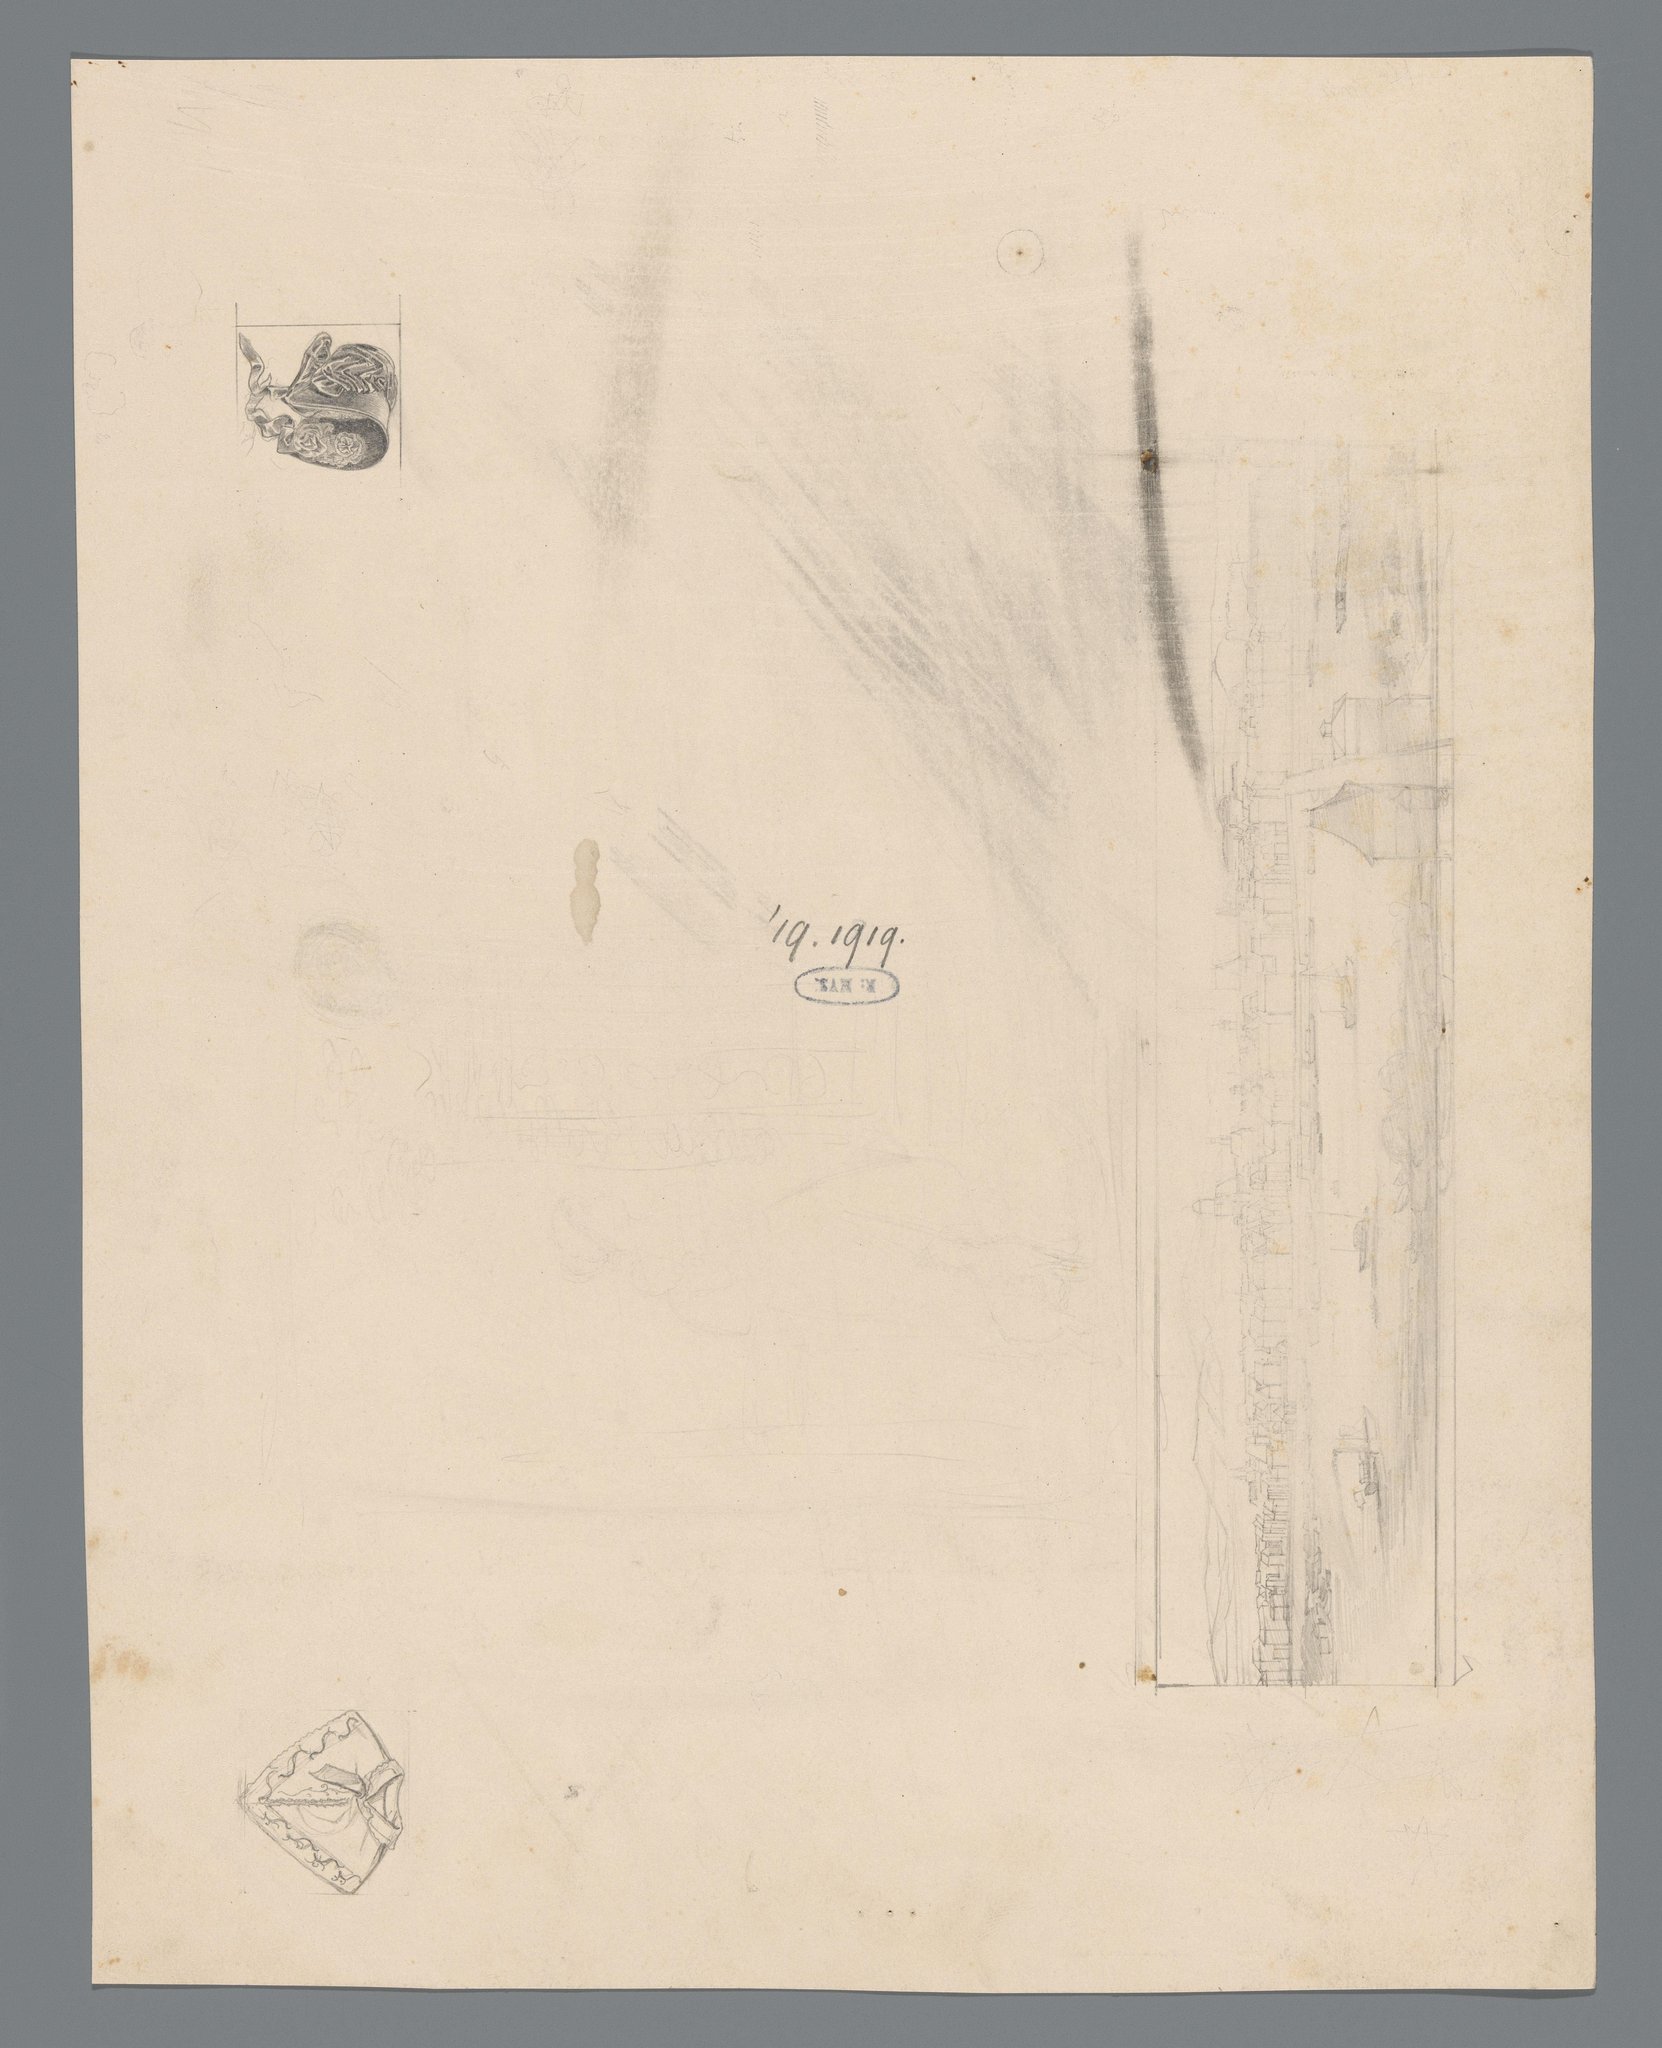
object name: drawing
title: Voorstellingen van een hoed, omslagdoek en stadsgezicht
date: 1820-1860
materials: paper, pencil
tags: city-view, and landscape with man-made constructions, head-gear, clothing for the upper part of the body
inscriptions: collector's mark: Lugt 2228